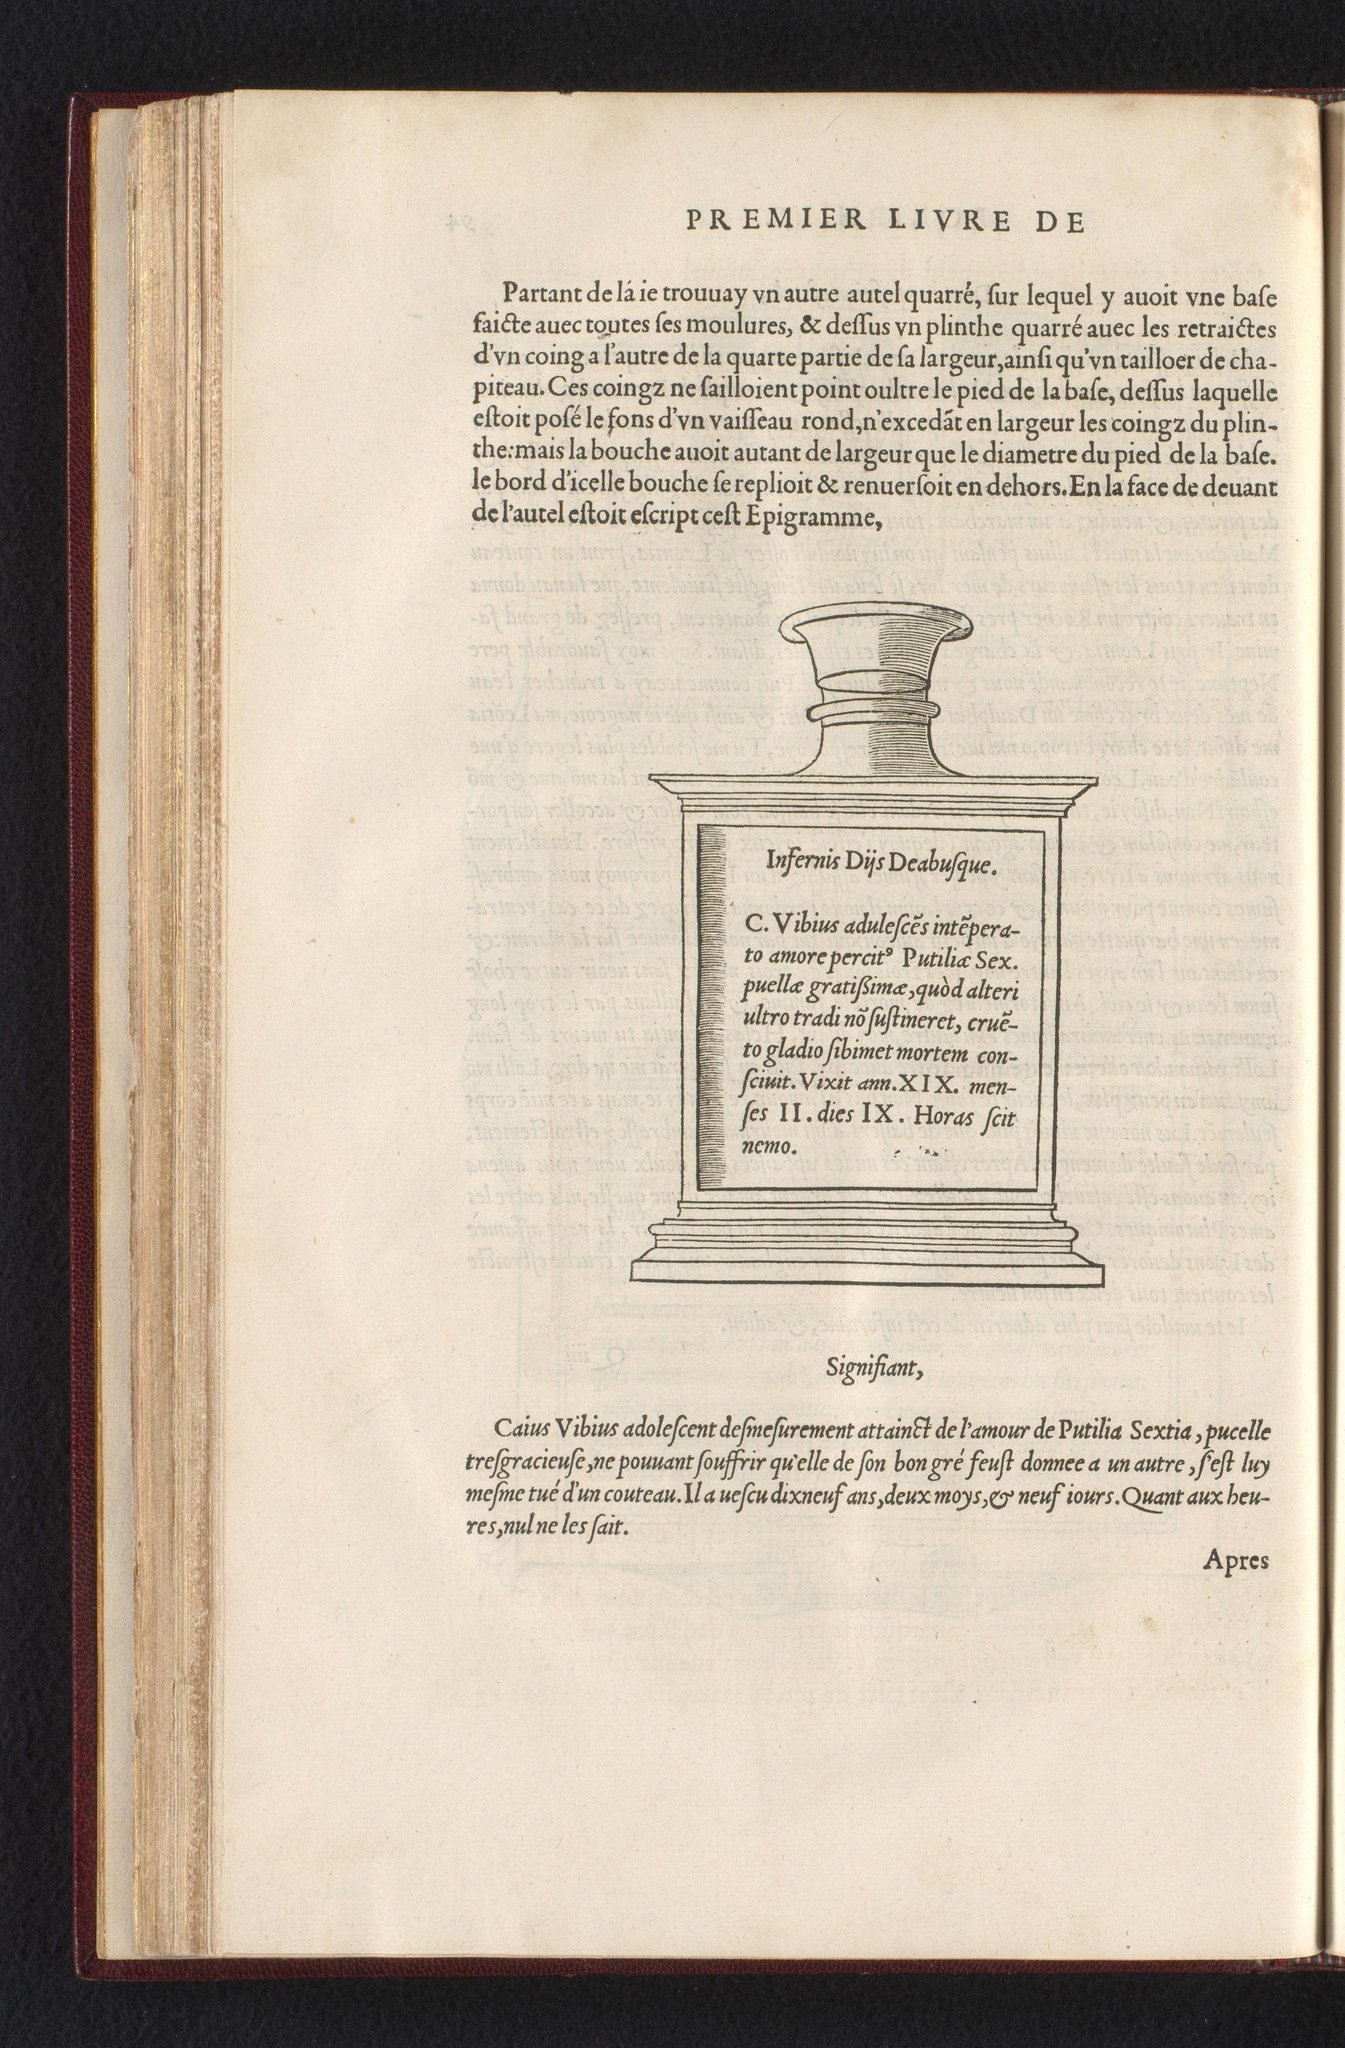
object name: page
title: Basement van een zuil met opschrift in het Latijn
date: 1546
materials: paper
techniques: letterpress printing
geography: paris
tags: inscription, (scenes from) specific works of literature: colonna, hypnerotomachia poliphili, base (~ column, pillar)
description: Prent uit: Colonna, Francesco. Hypnerotomachie ou discours du songe de Poliphile, deduisant comme amour le combat a l'occasion de Polia. Parijs: Jacques Kerver, 1546, verso fol. 94.